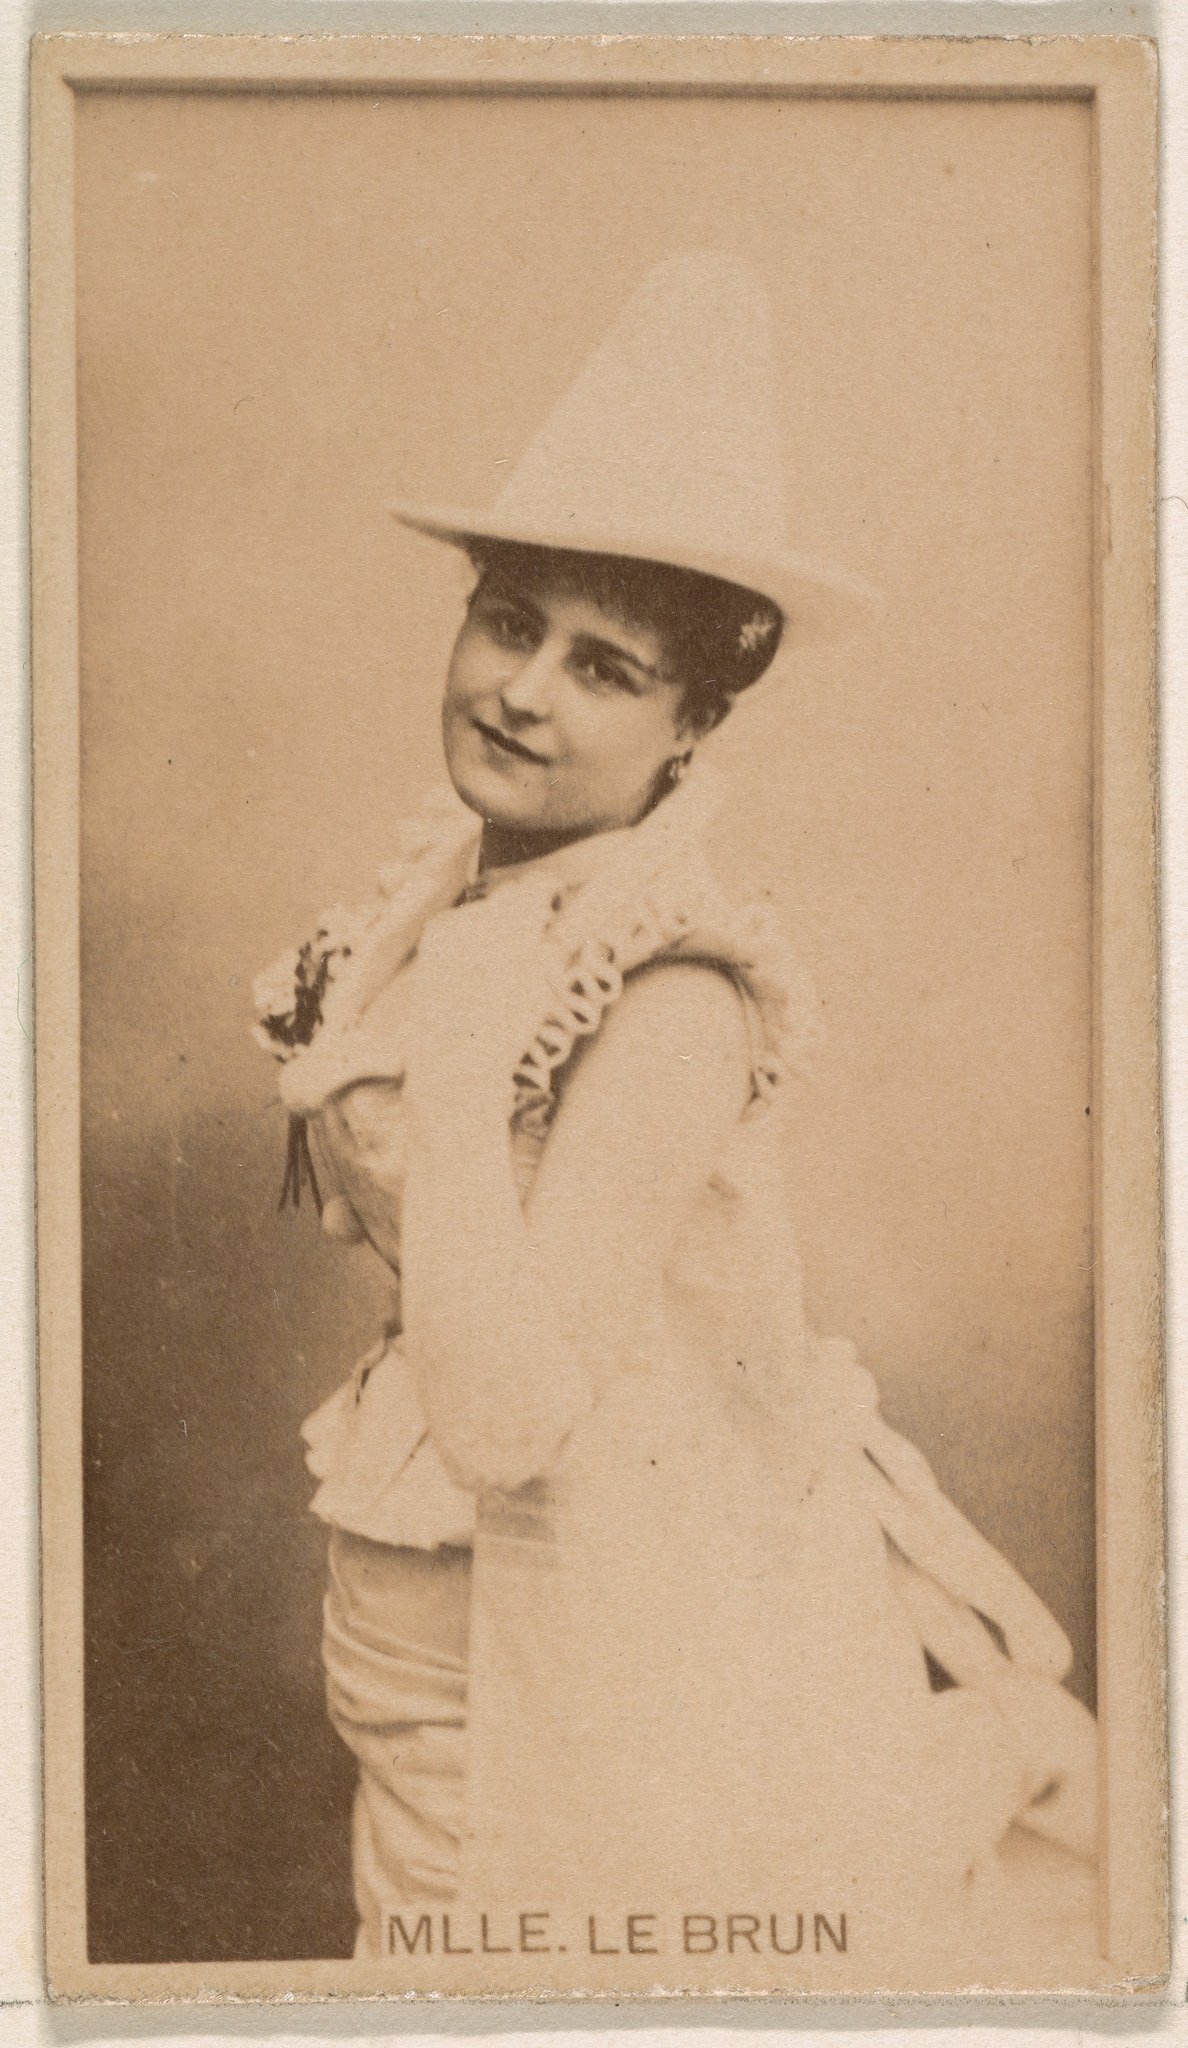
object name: photograph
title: Mlle. Le Brun, from the Actresses series (N245) issued by Kinney Brothers to promote Sweet Caporal Cigarettes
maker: kinney brothers tobacco company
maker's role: publisher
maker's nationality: american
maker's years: 1869-2011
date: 1890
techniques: albumen silver print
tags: portraits,women,actresses